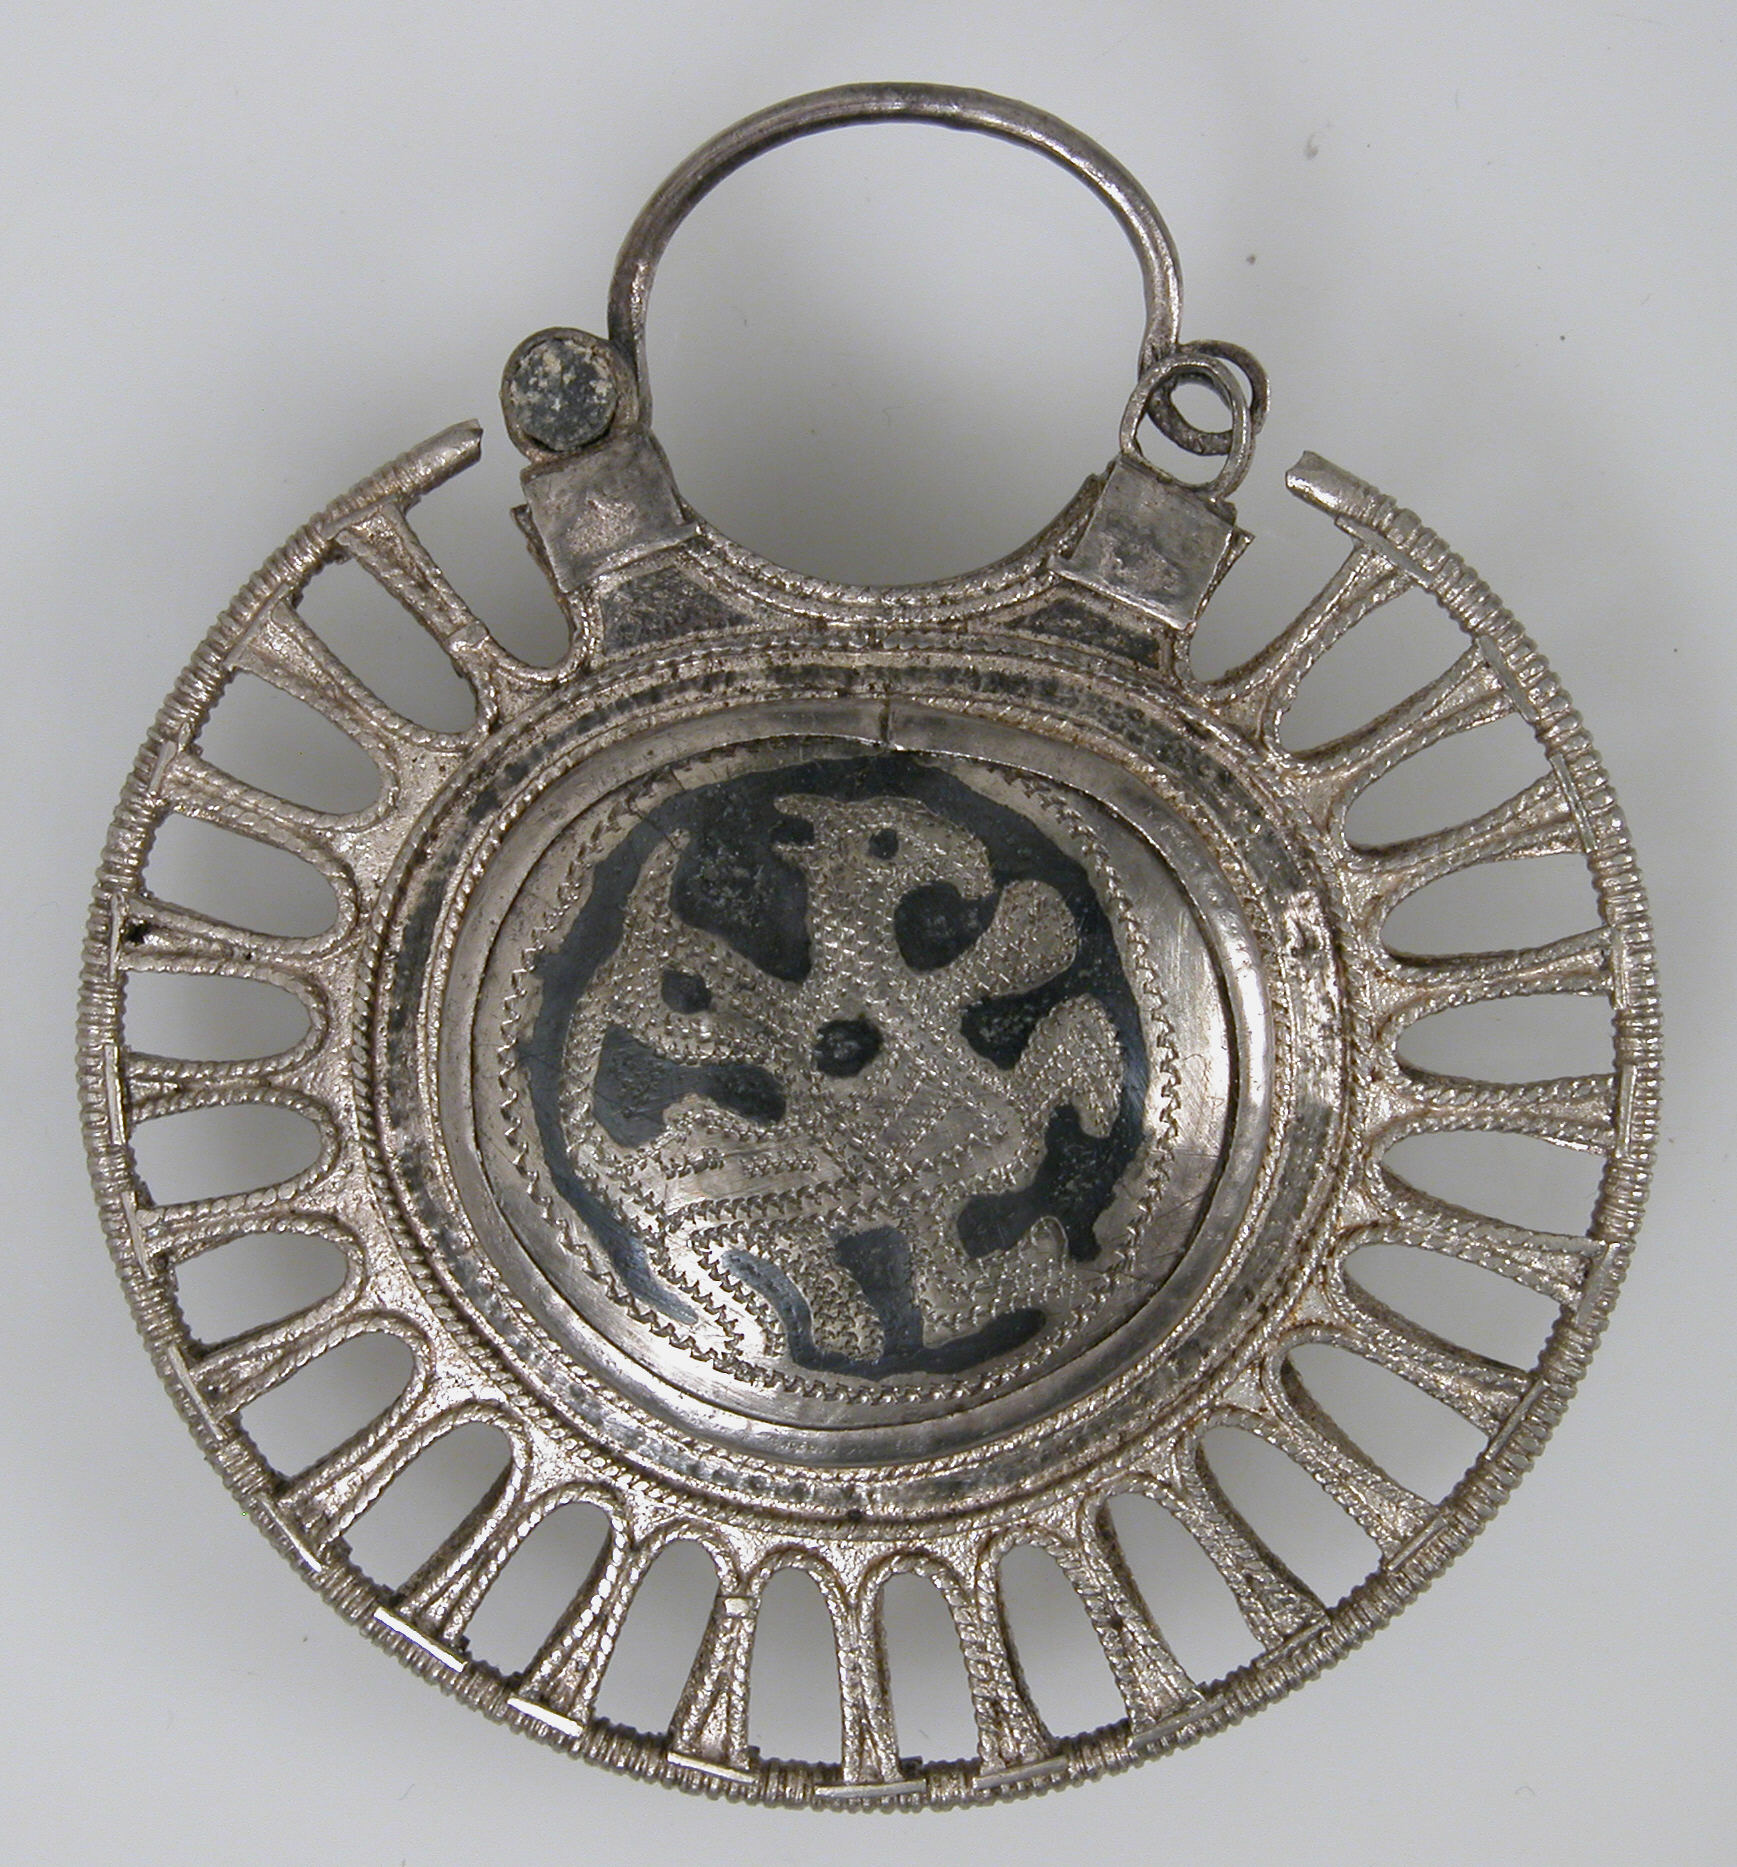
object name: temple pendant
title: Temple Pendant with Filigree Border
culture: kyivan rus’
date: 1001-1200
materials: niello, silver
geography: ukraine